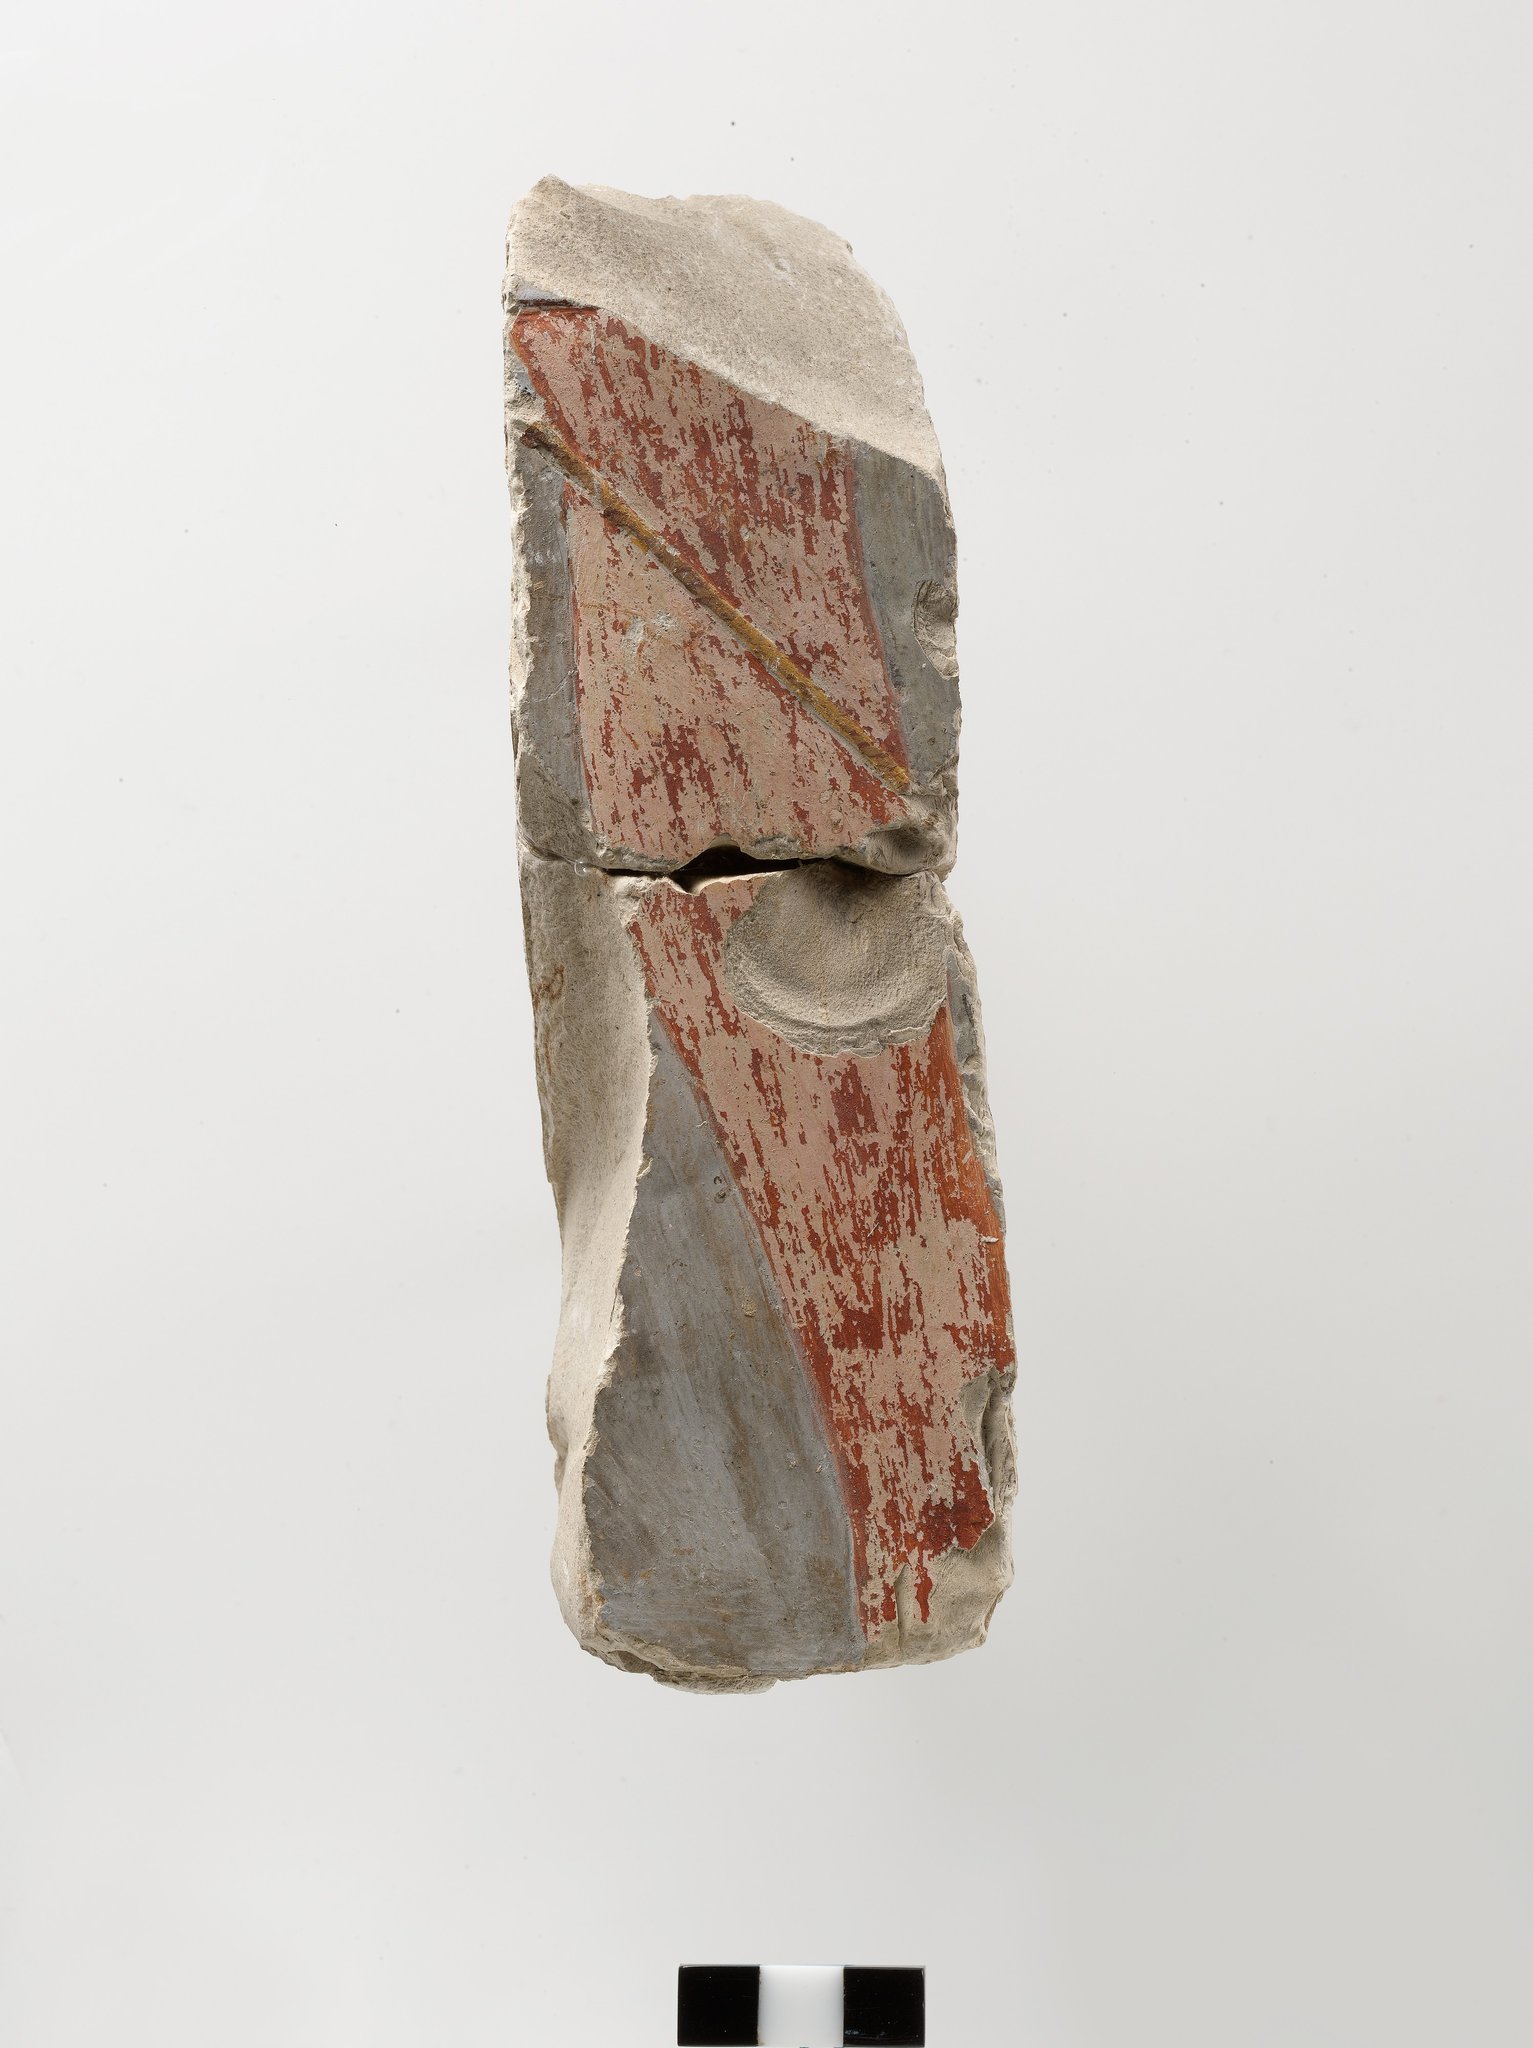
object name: relief fragment, tomb of meketre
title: Relief fragment from tomb of Meketre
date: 1981-1975 BCE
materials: limestone, paint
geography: egypt